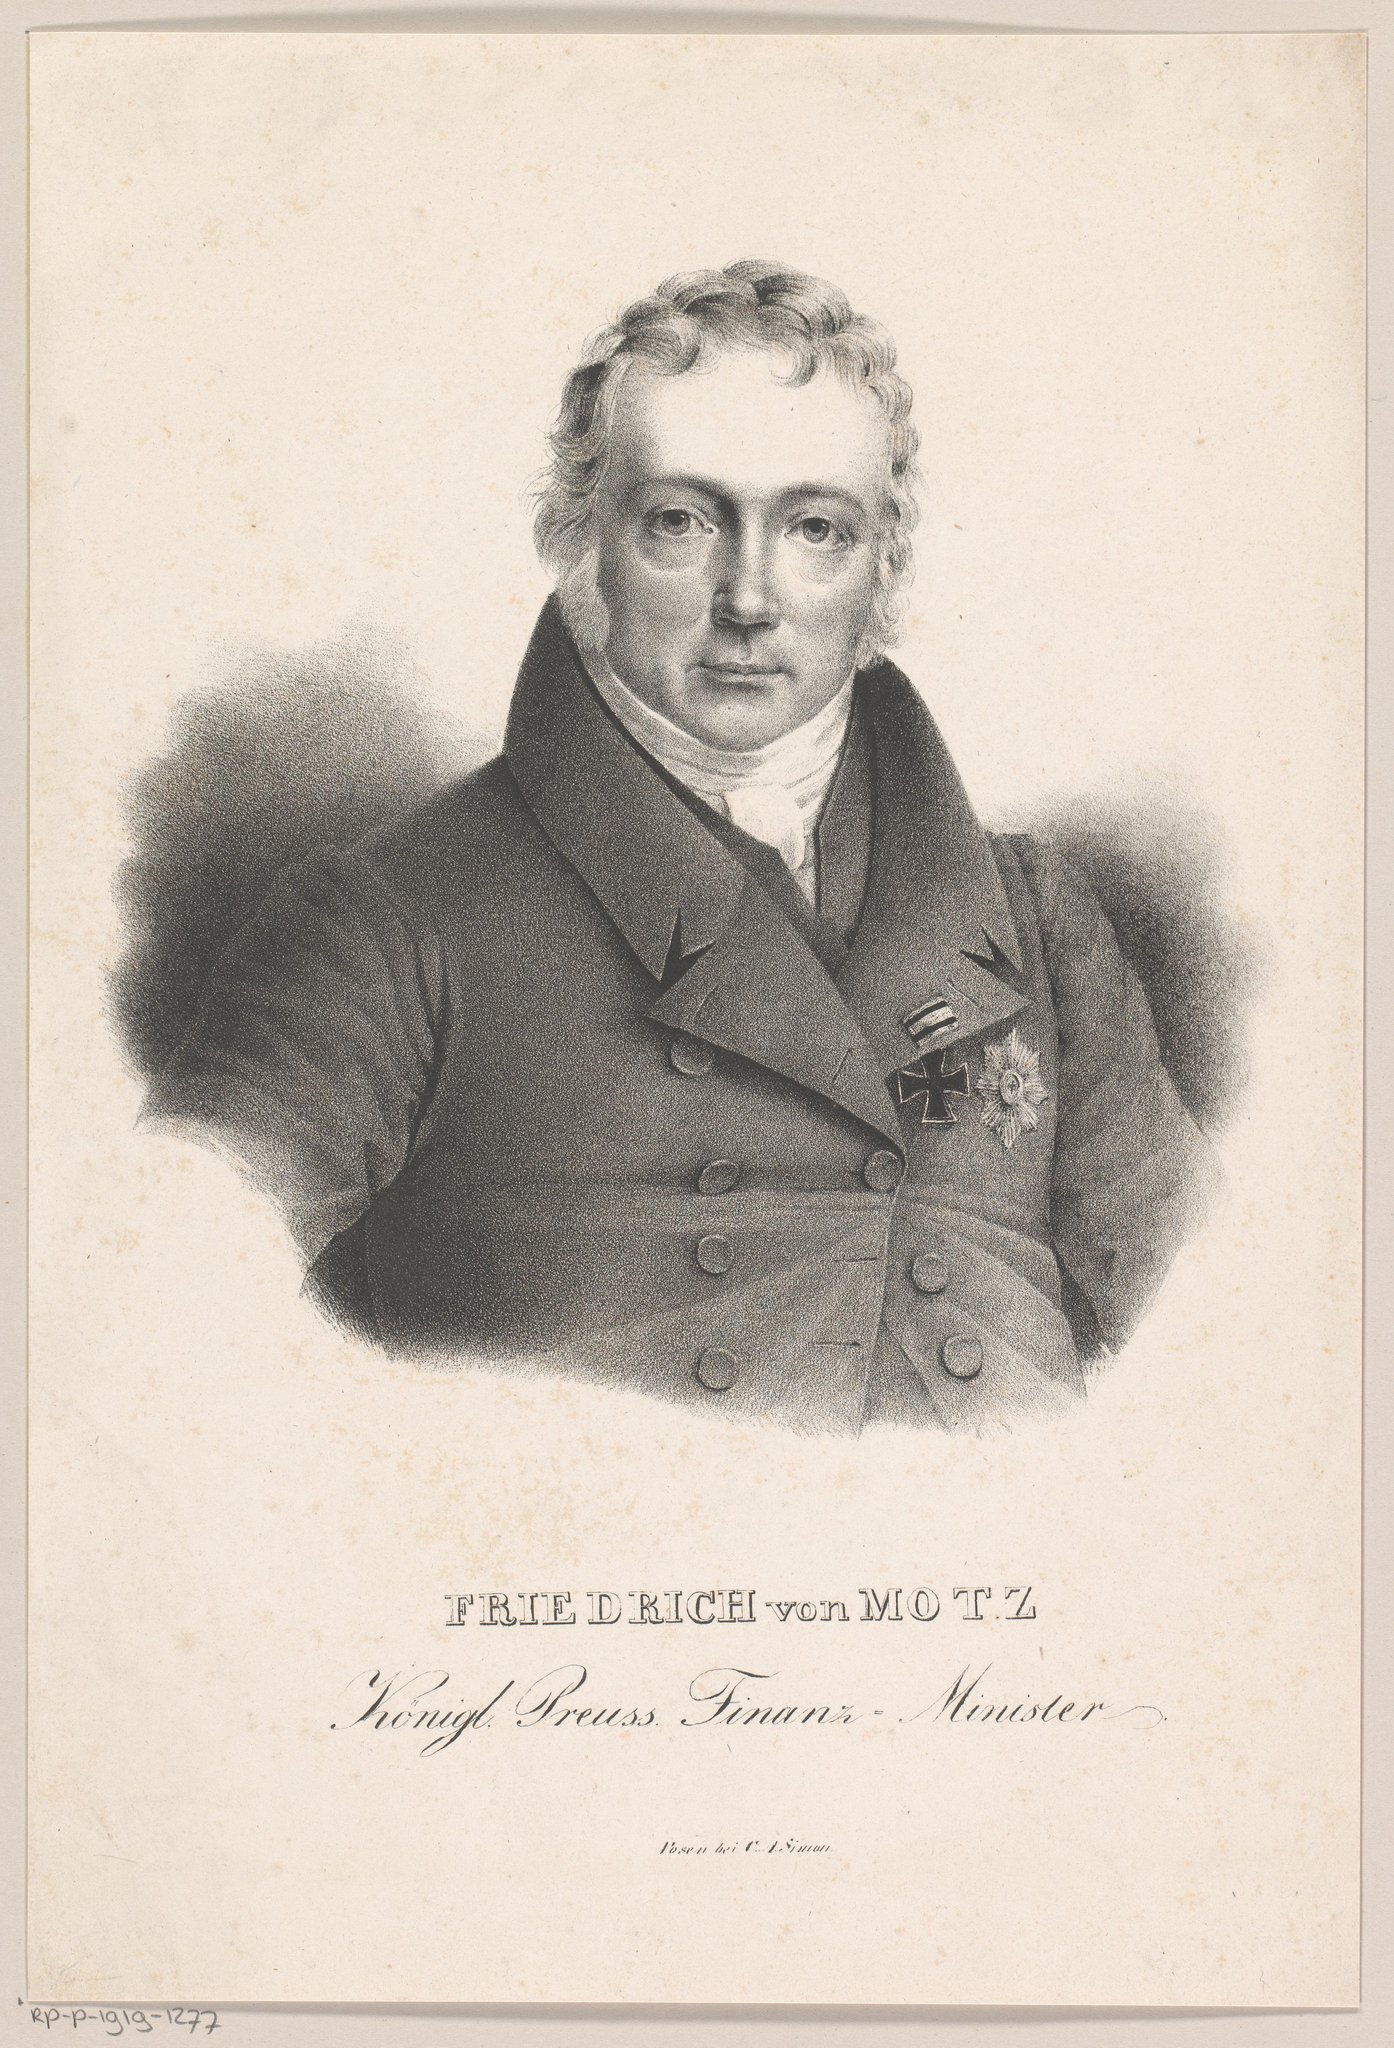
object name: print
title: Portret van Friedrich von Motz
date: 1825-1850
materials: paper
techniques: lithograph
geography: poznan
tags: berlin, historical persons, politician, e.g. party leader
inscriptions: collector's mark: Lugt 2228